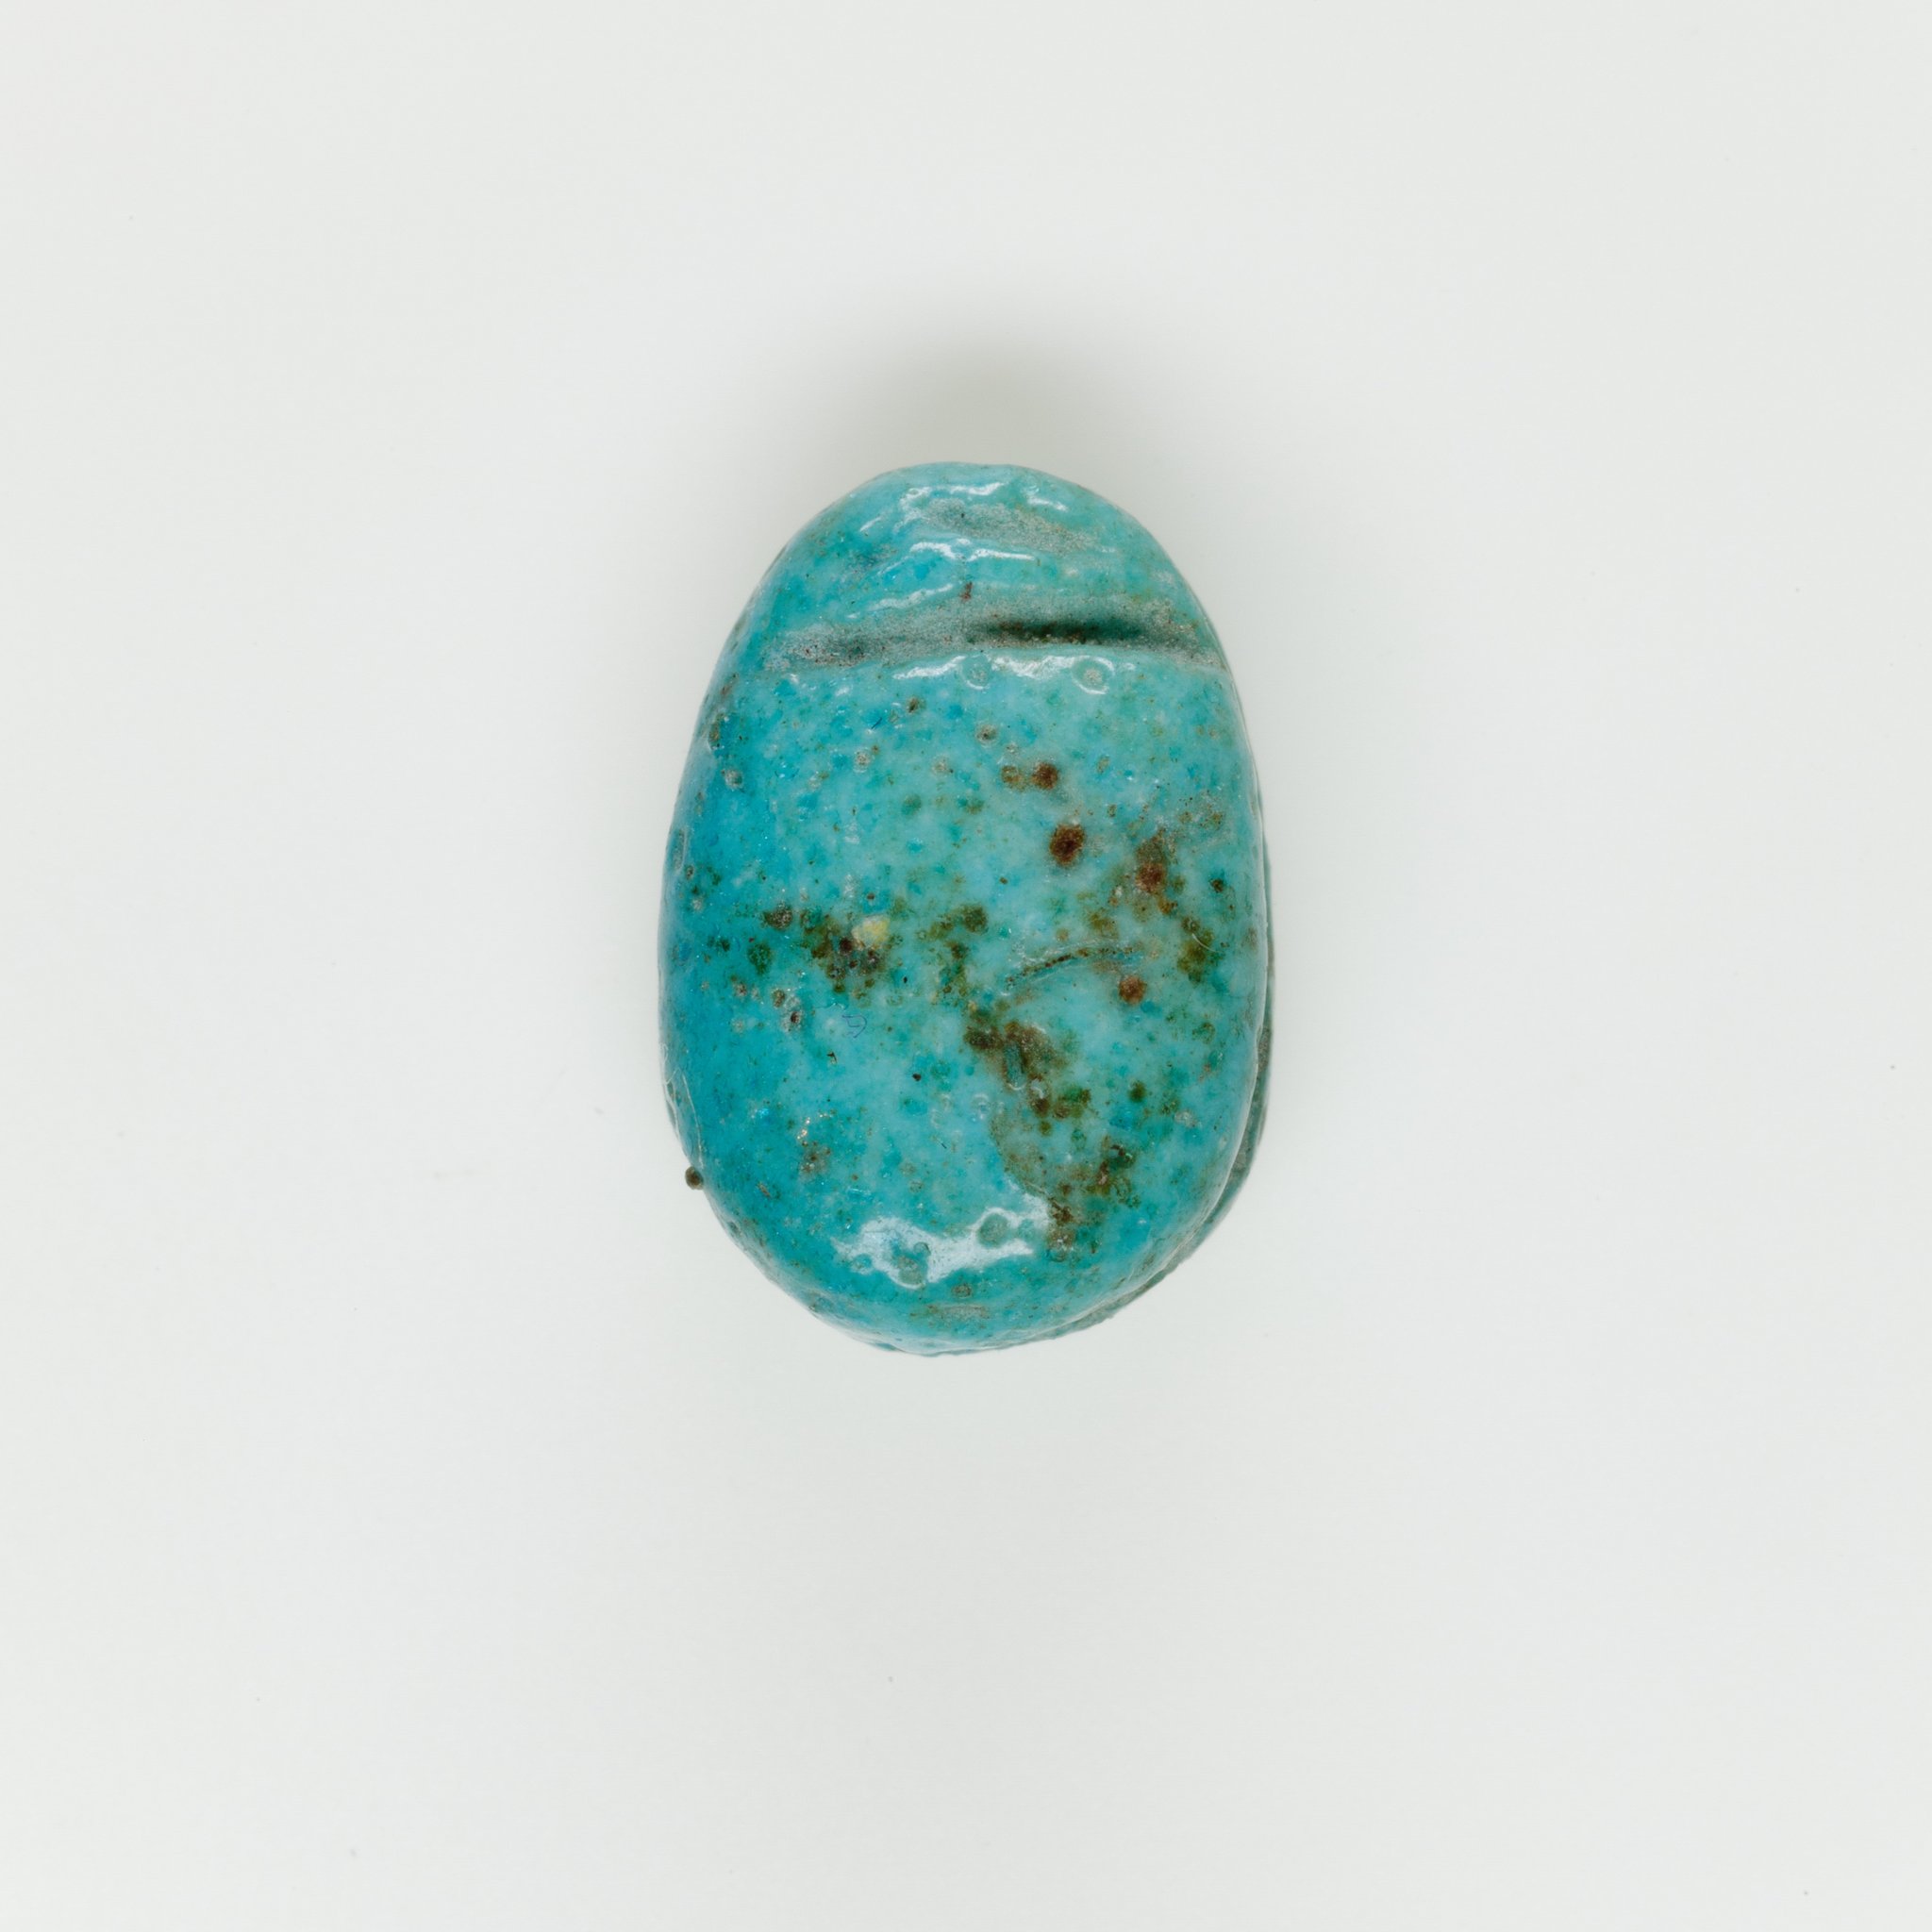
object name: bead, scarab, amenemhat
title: Uninscribed Scarab Bead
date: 1504-1447 BCE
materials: faience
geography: egypt